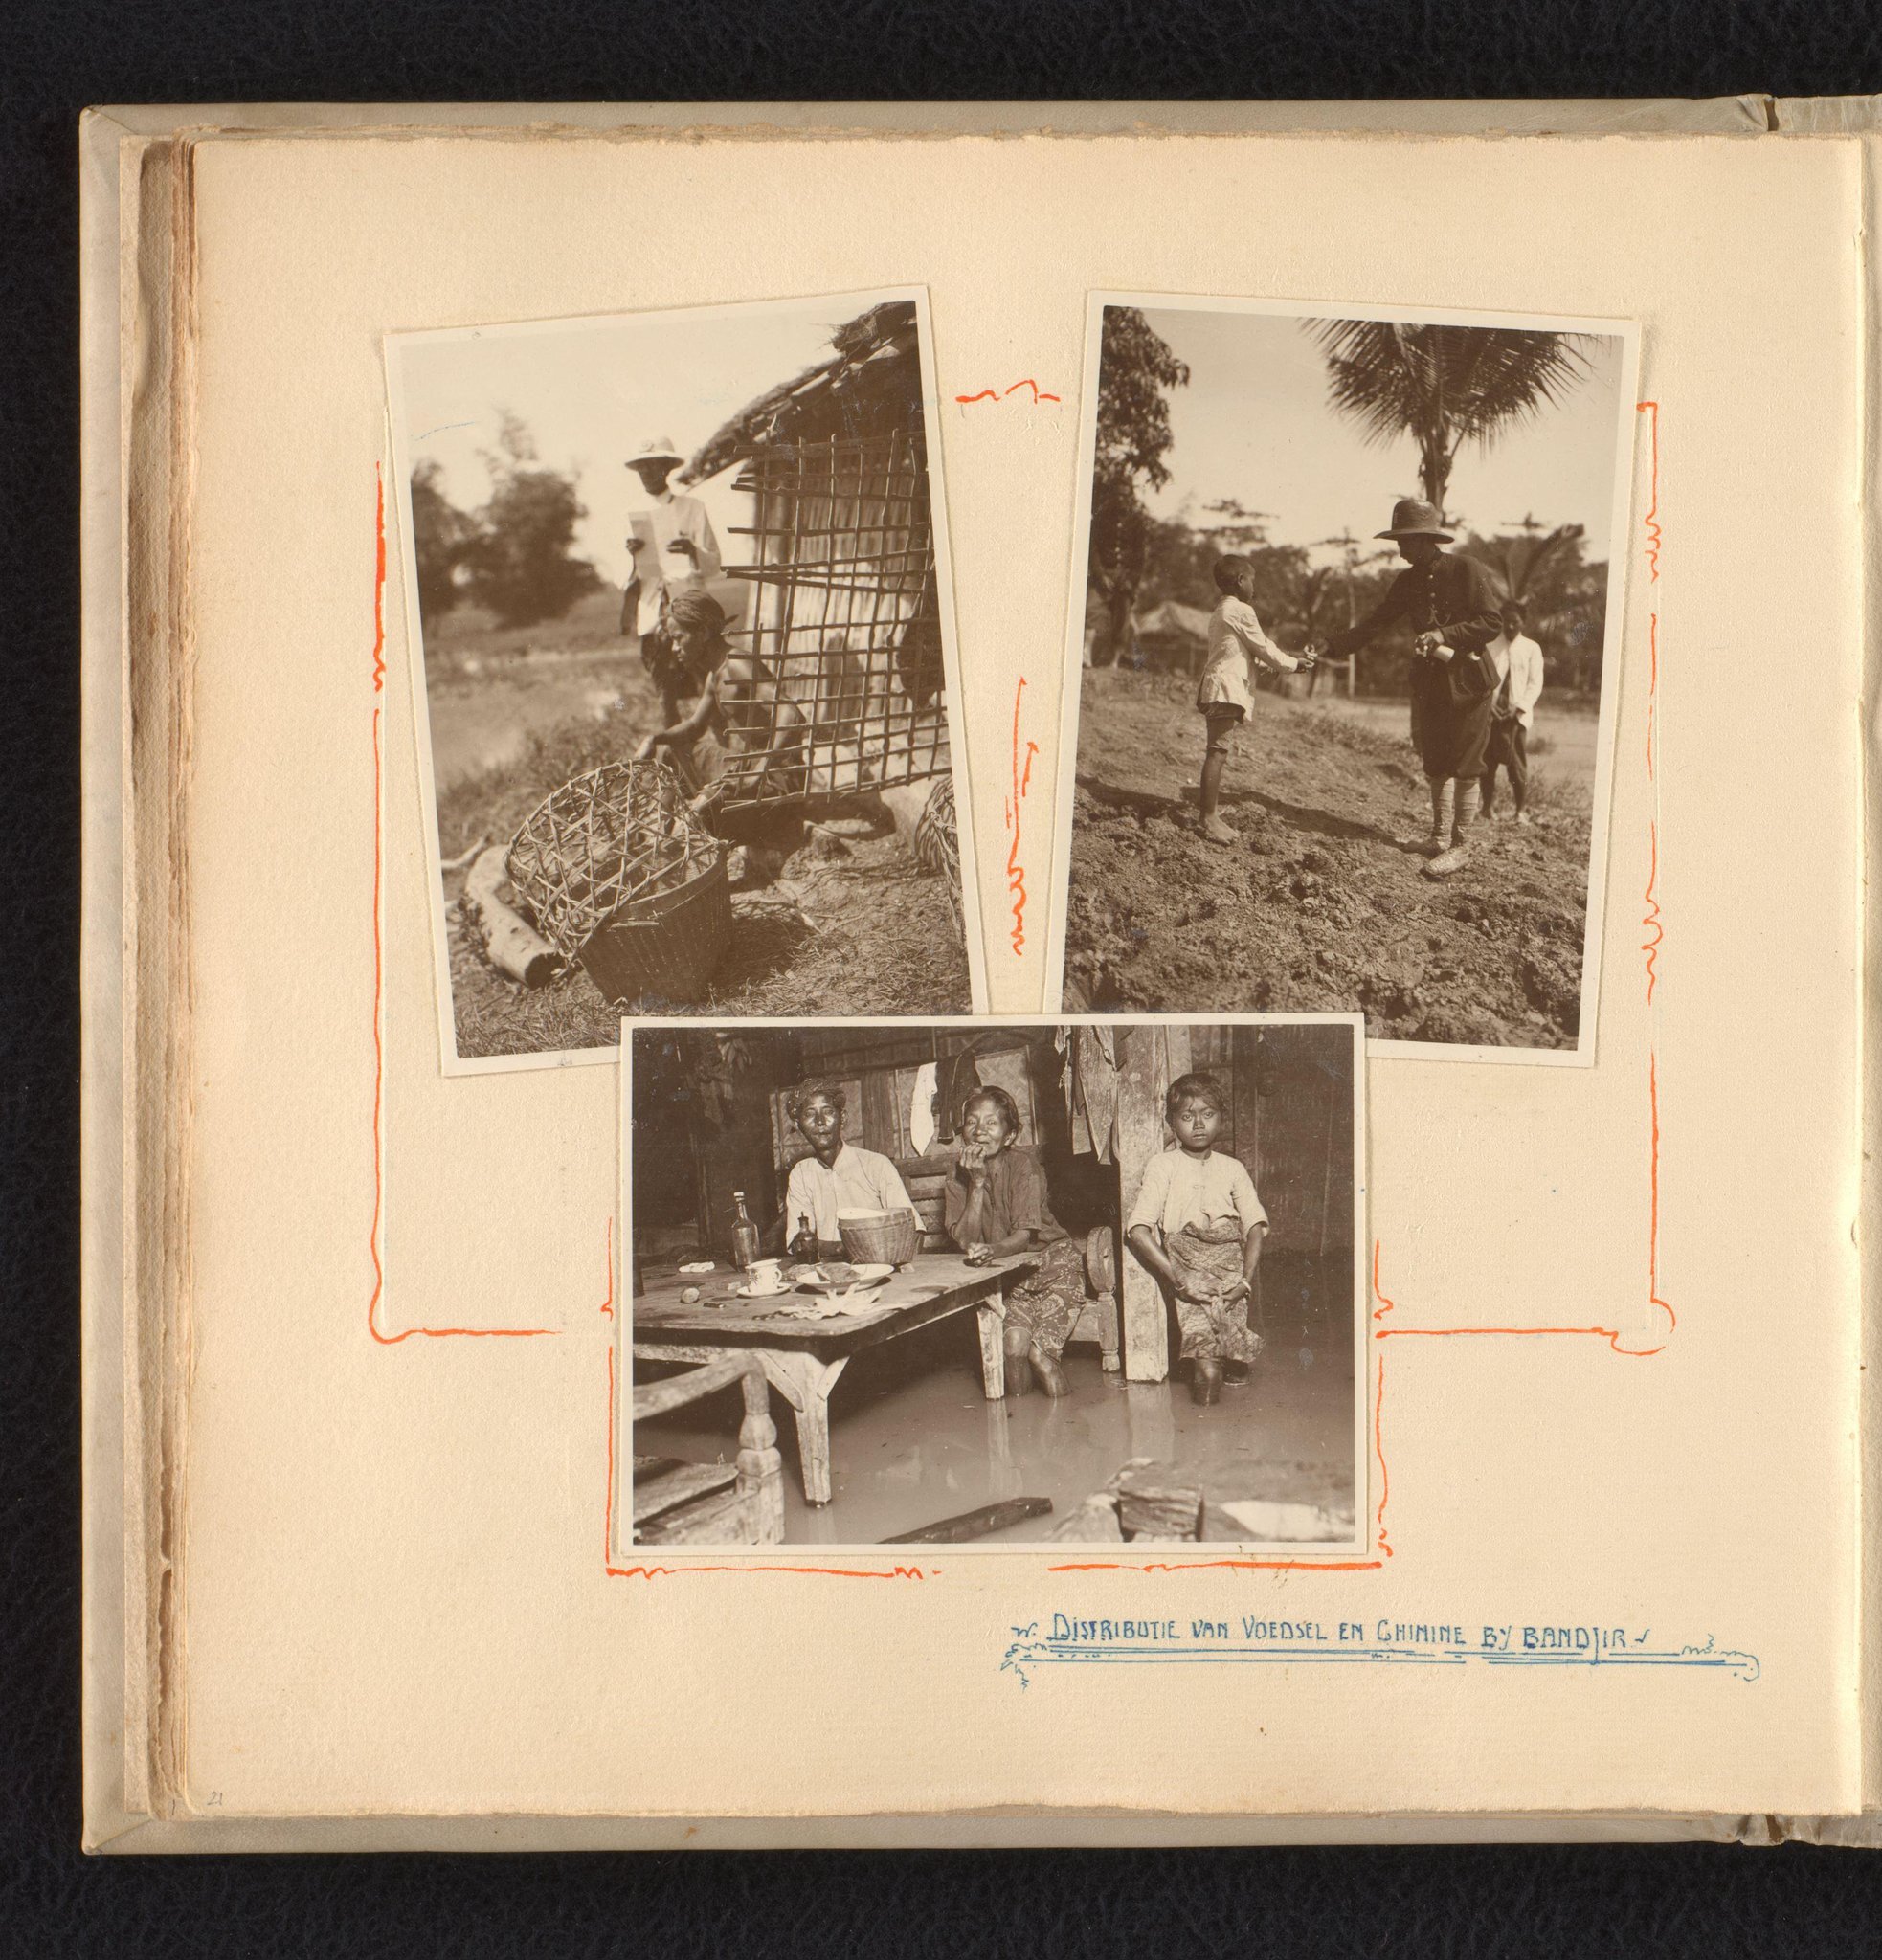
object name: photograph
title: Distributie van voedsel en kinine in Banjir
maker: Anonymous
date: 1910-1928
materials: paper, photographic support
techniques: drawing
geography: grobogan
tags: administering, taking medicine, medicament, medicine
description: Albumblad met drie foto's van de distributie van voedsel en kinine in Banjir (Bandjir) in Grobogan. Het blad is versierd met randwerk om de foto's. Onderdeel van het fotoalbum aangeboden aan J. Habbema door het Binnenlandsch Bestuur Corps van het Regentschap Grobogan, bij het beëindigen van zijn bestuur over het Regentschap, waarschijnlijk in 1928.